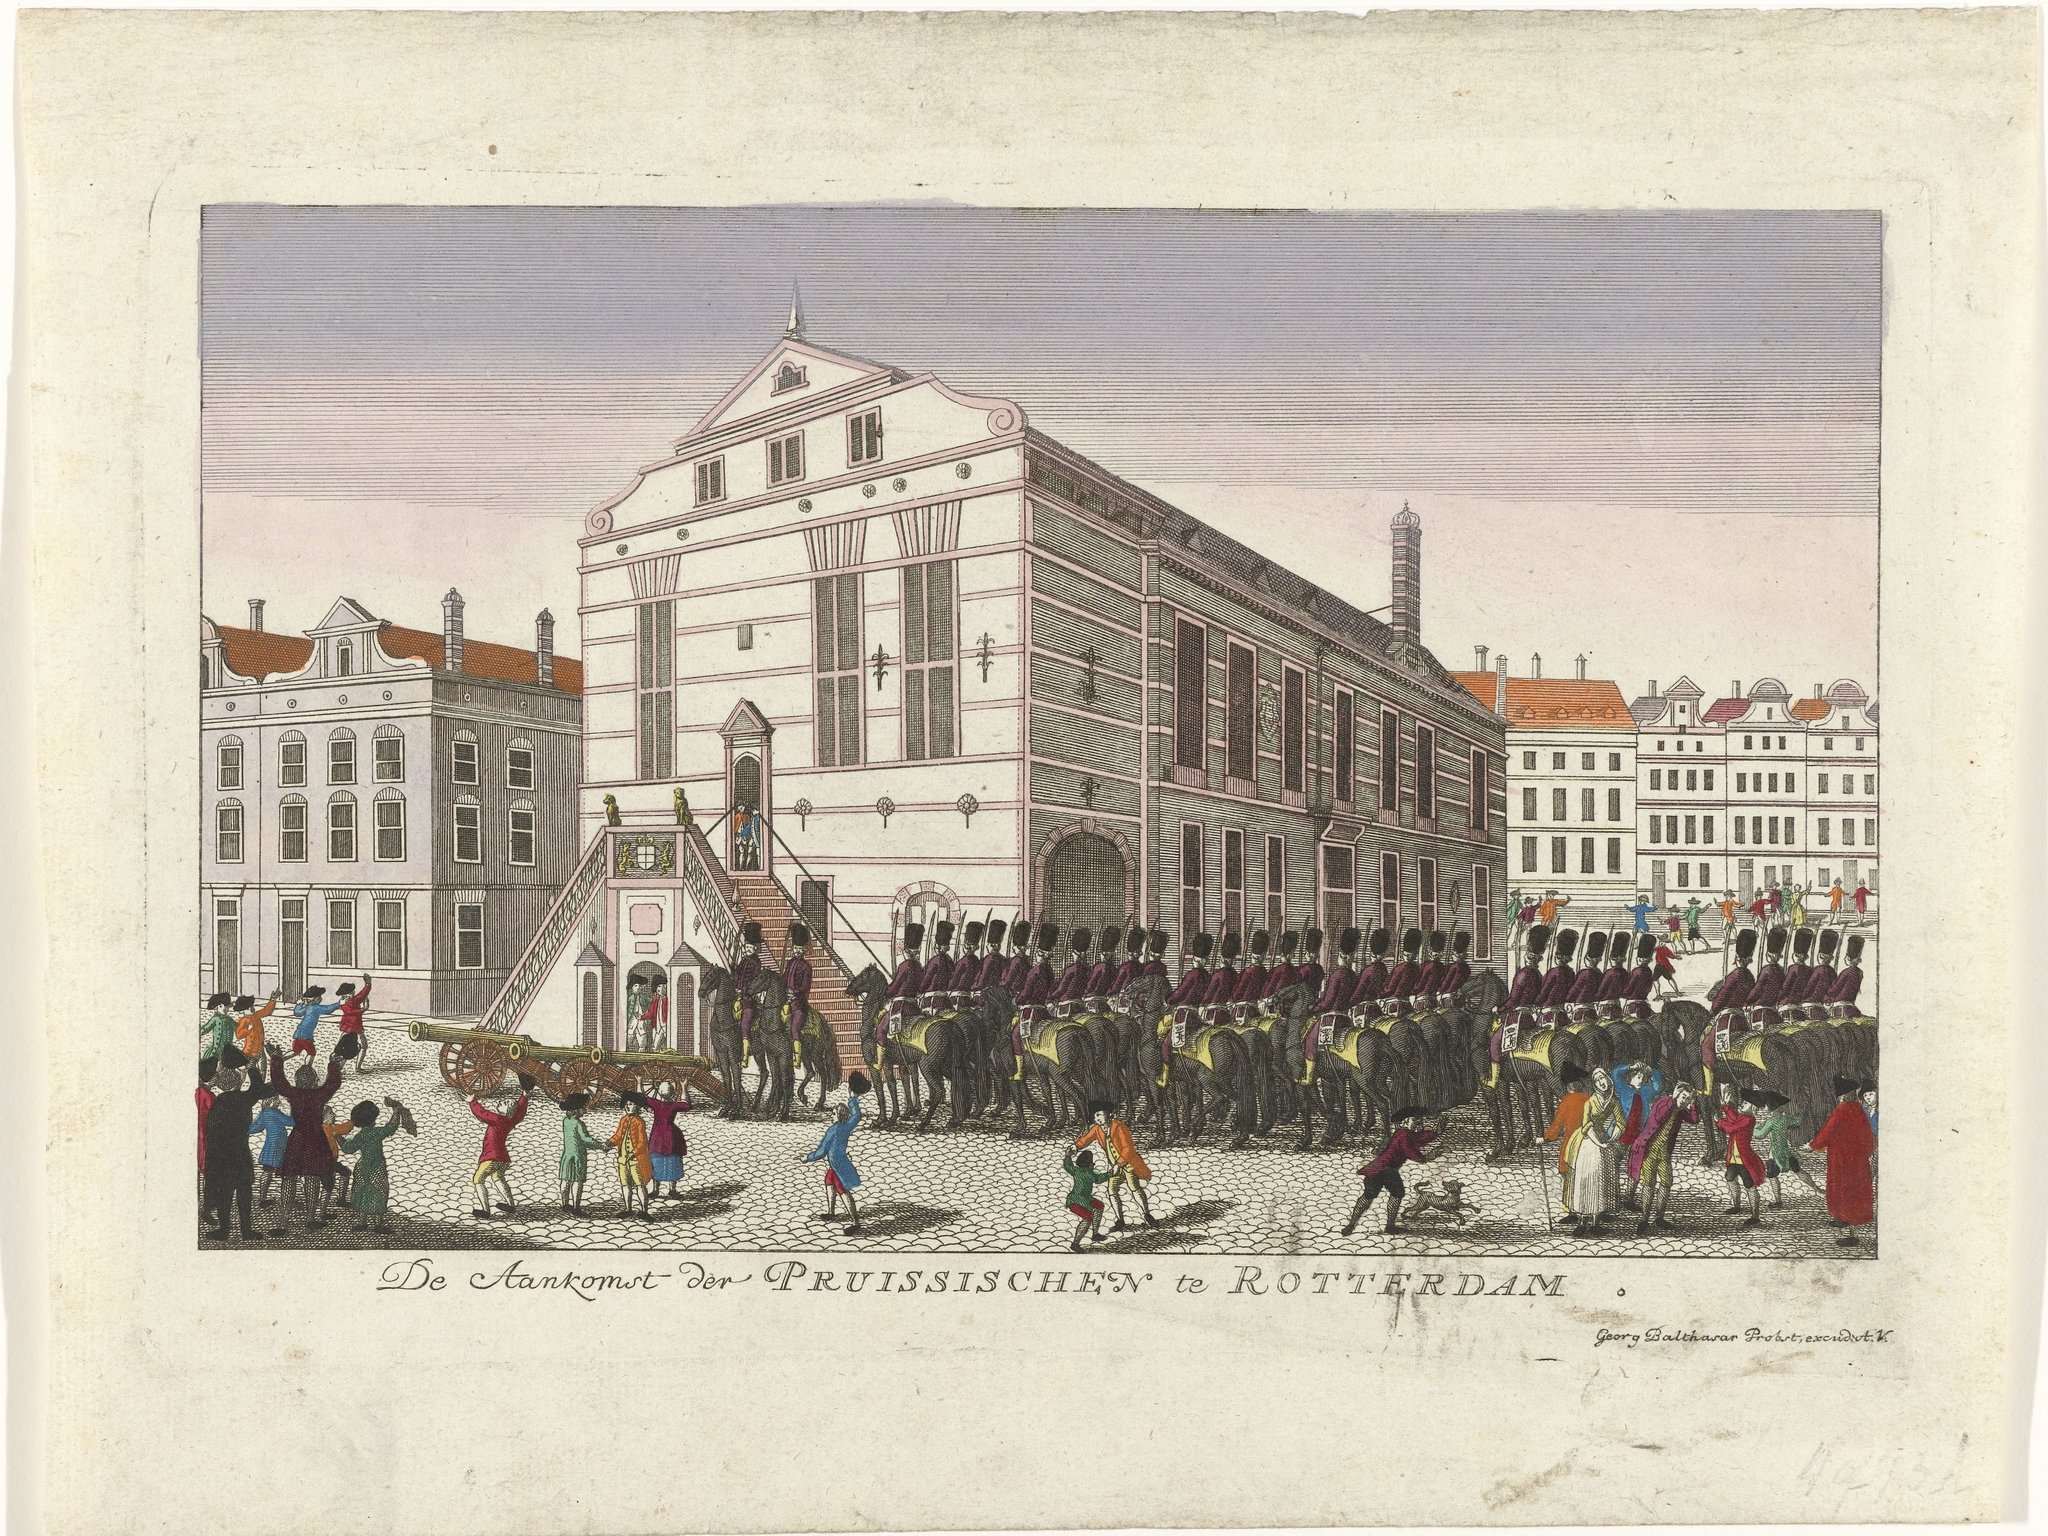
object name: print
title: Aankomst Pruisische troepen te Rotterdam, 1787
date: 1787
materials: paper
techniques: etching, hand coloring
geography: augsburg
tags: stadhuis, pruisische inval in de republiek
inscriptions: collector's mark: Lugt 2228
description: Aankomst van een detachement Pruisische huzaren bij het stadhuis van Rotterdam, 20 september 1787.